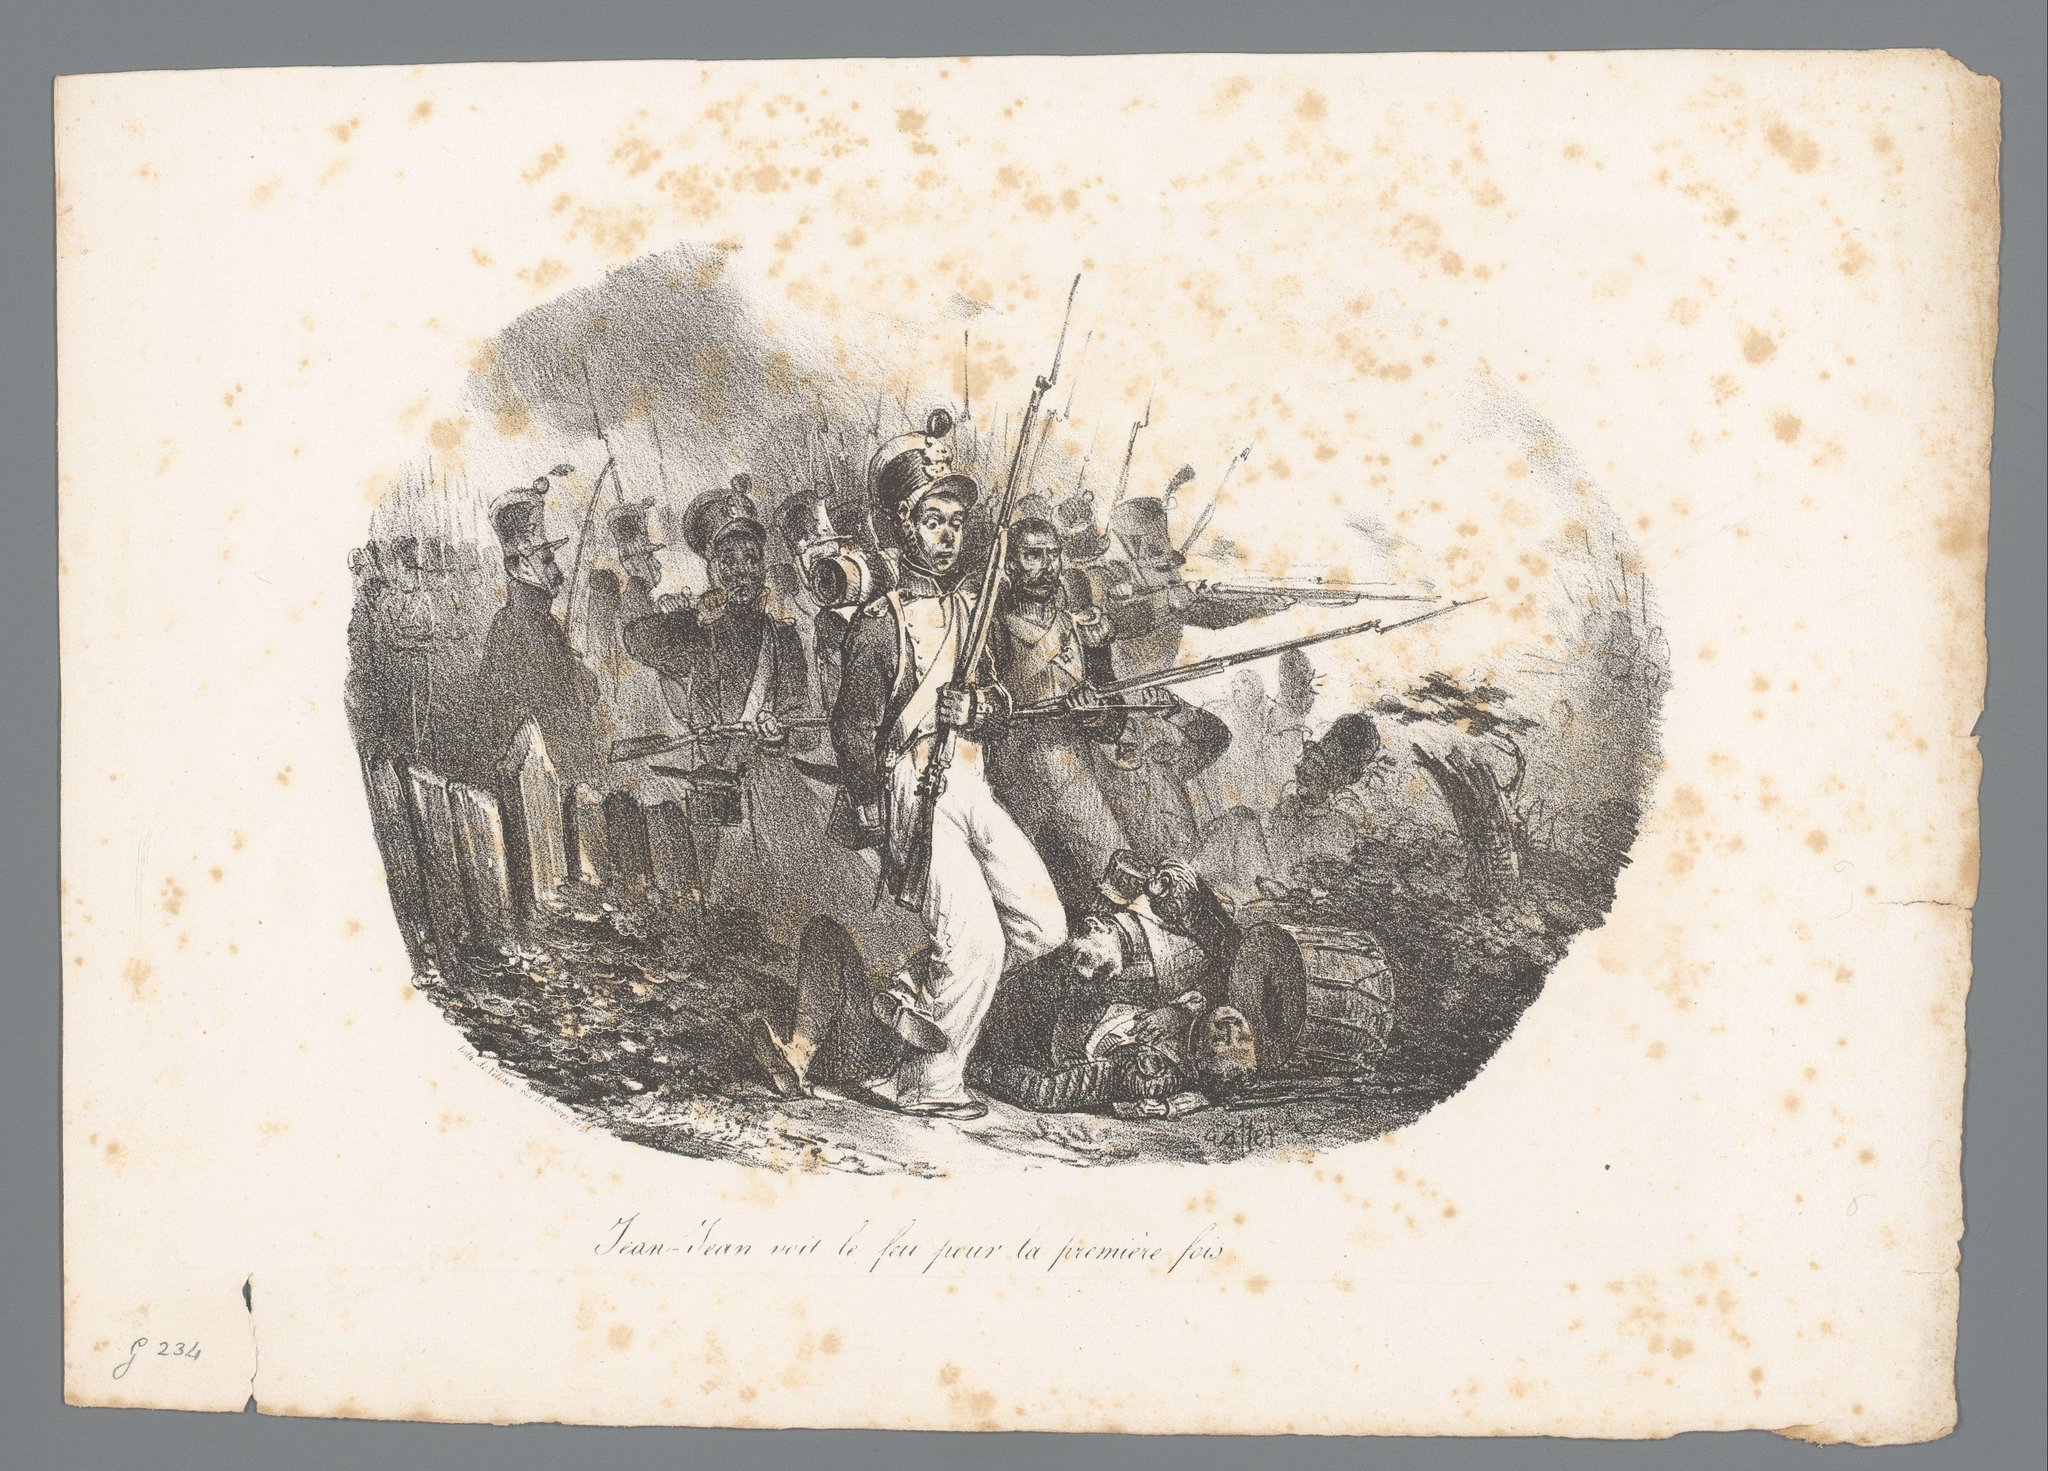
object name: print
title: Verhaal over Jean-Jean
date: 1825-1829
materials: paper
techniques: lithograph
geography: paris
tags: battle, firearms: rifle, the soldier; the soldier's life, death of human being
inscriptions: collector's mark: Lugt 964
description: Serie bestaat uit titelprent en zestien prenten. Vijftiende prent in de serie van zeventien prenten.